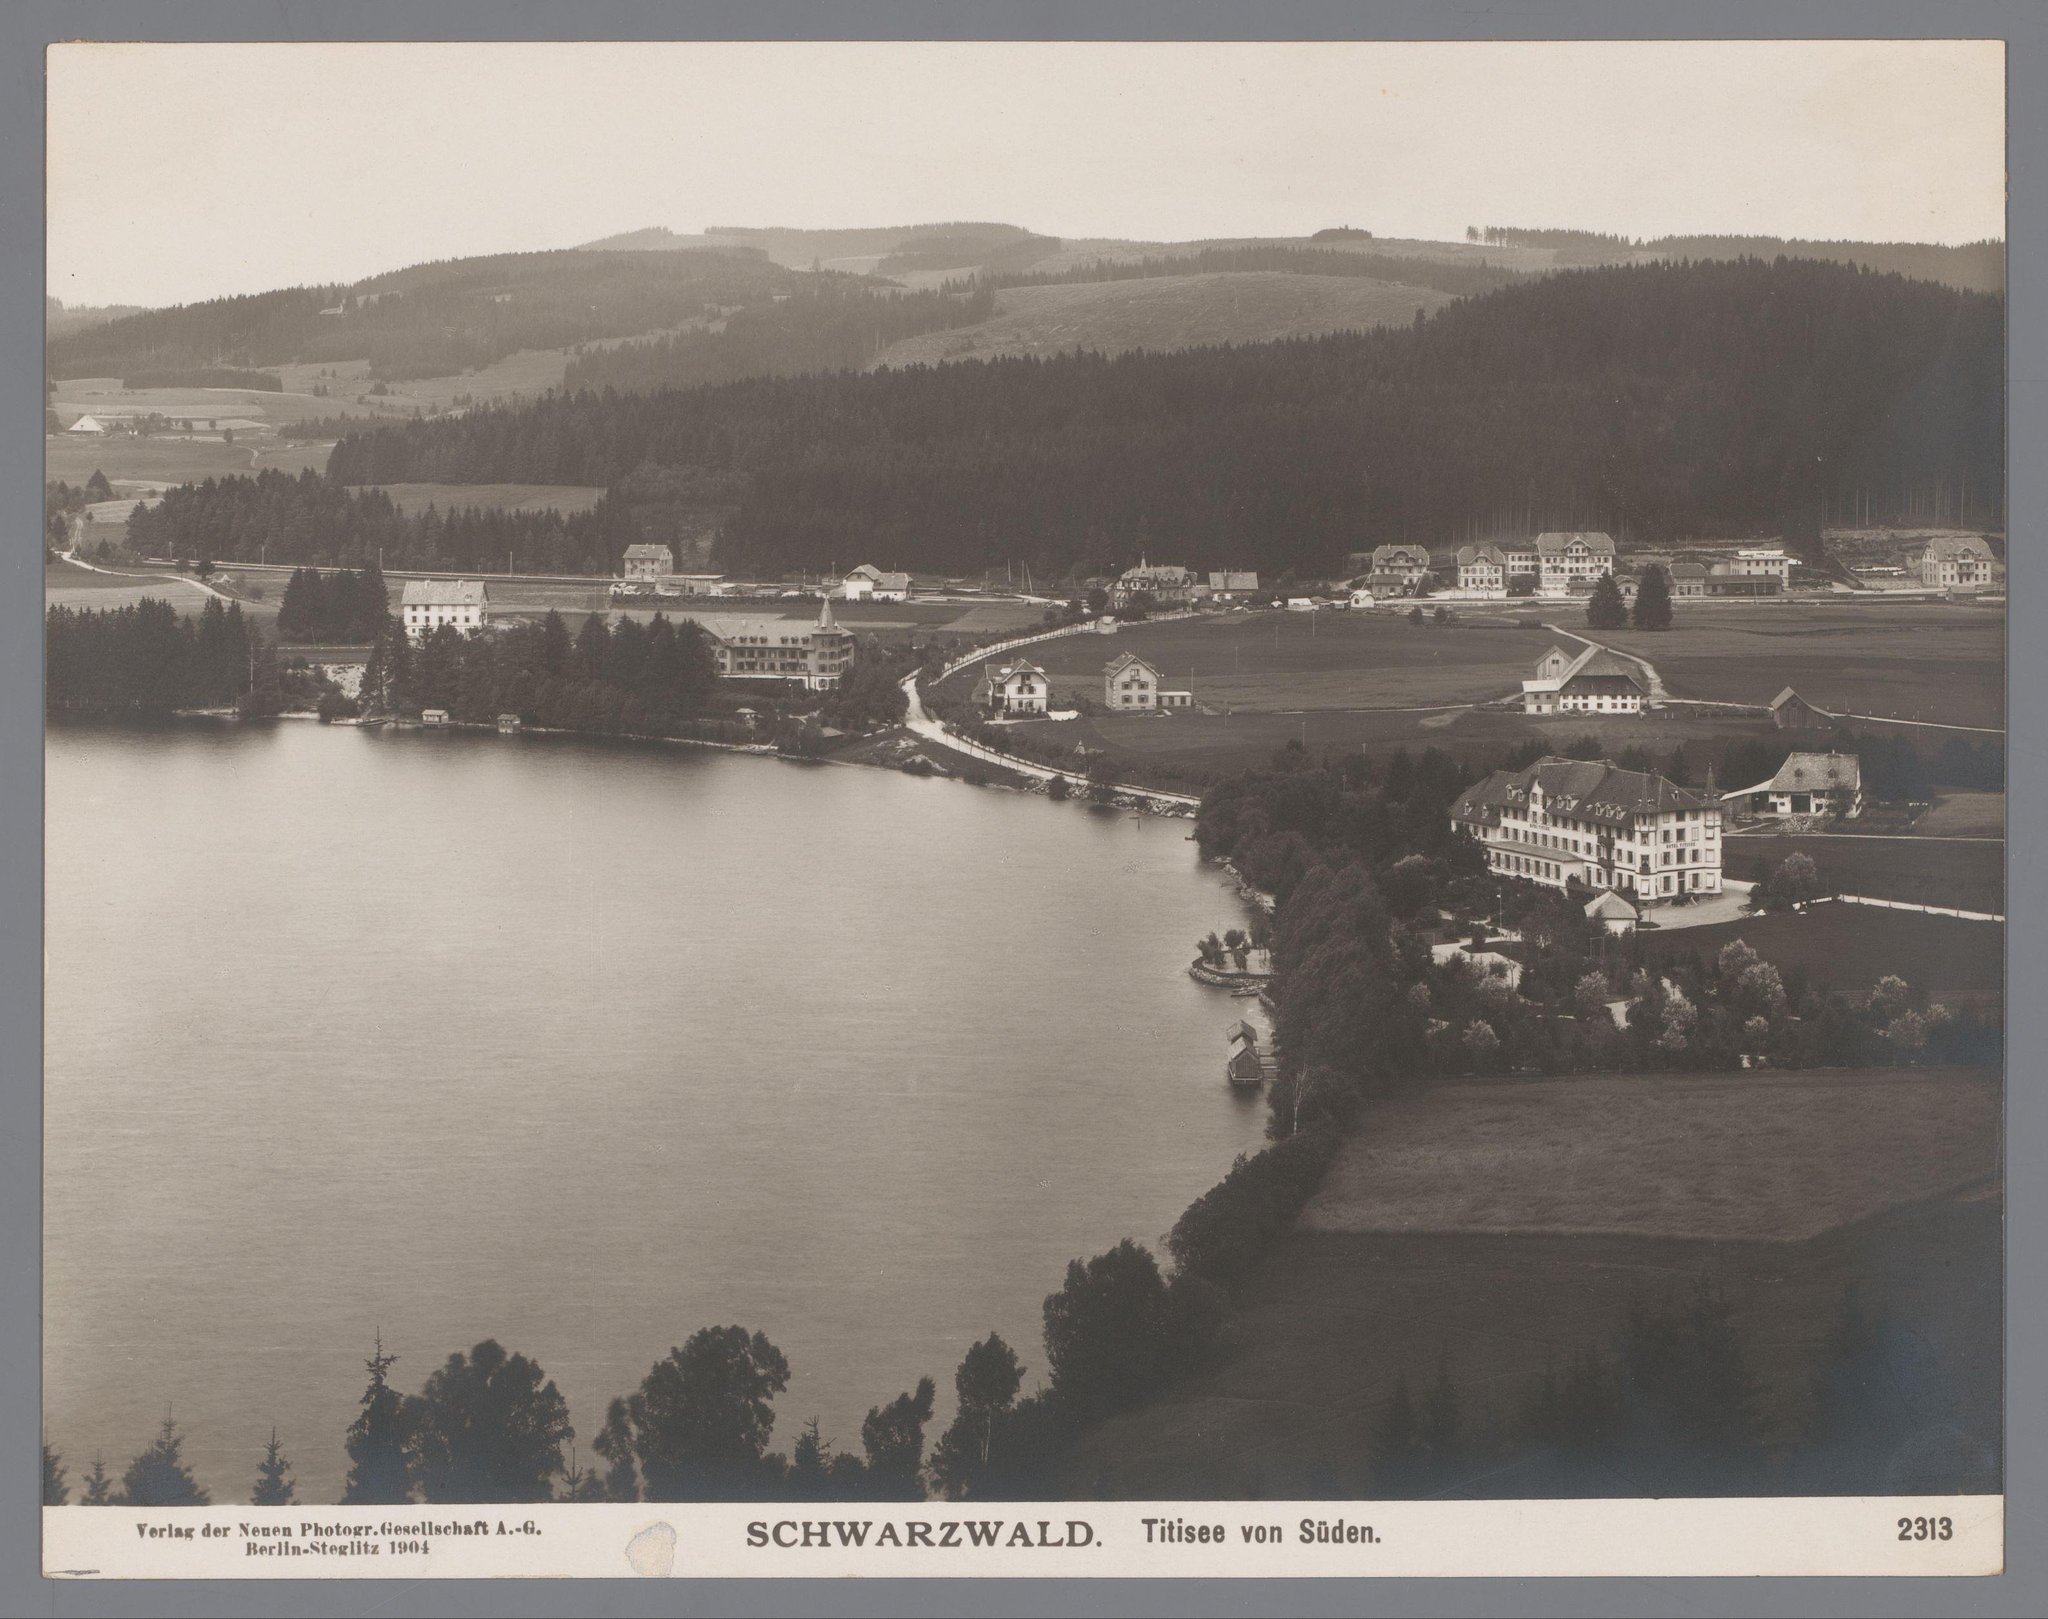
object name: photograph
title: Titisee, Zwarte Woud, Baden-Württemberg, Duitsland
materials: paper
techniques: gelatin silver print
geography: germany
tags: titisee-neustadt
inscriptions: inscription: ‘SCHWARZWALD. Titisee von Süden.’, number: ‘2313’, inscription: ‘Verlag der Neuen Photogr.Gesellschaft A.-G.//Berlin-Stieglitz 1904’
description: Het Zwarte Woud ligt aan de Rijn en aan de Franse grens. Op de noordelijke oever van het meer, dat 1,3m2 km beslaat, ligt het gelijknamige kuuroord, tegenwoordig een onderdeel van de stad Titisee-Neustadt. Hier zien we Titisee vanuit het Zuiden.